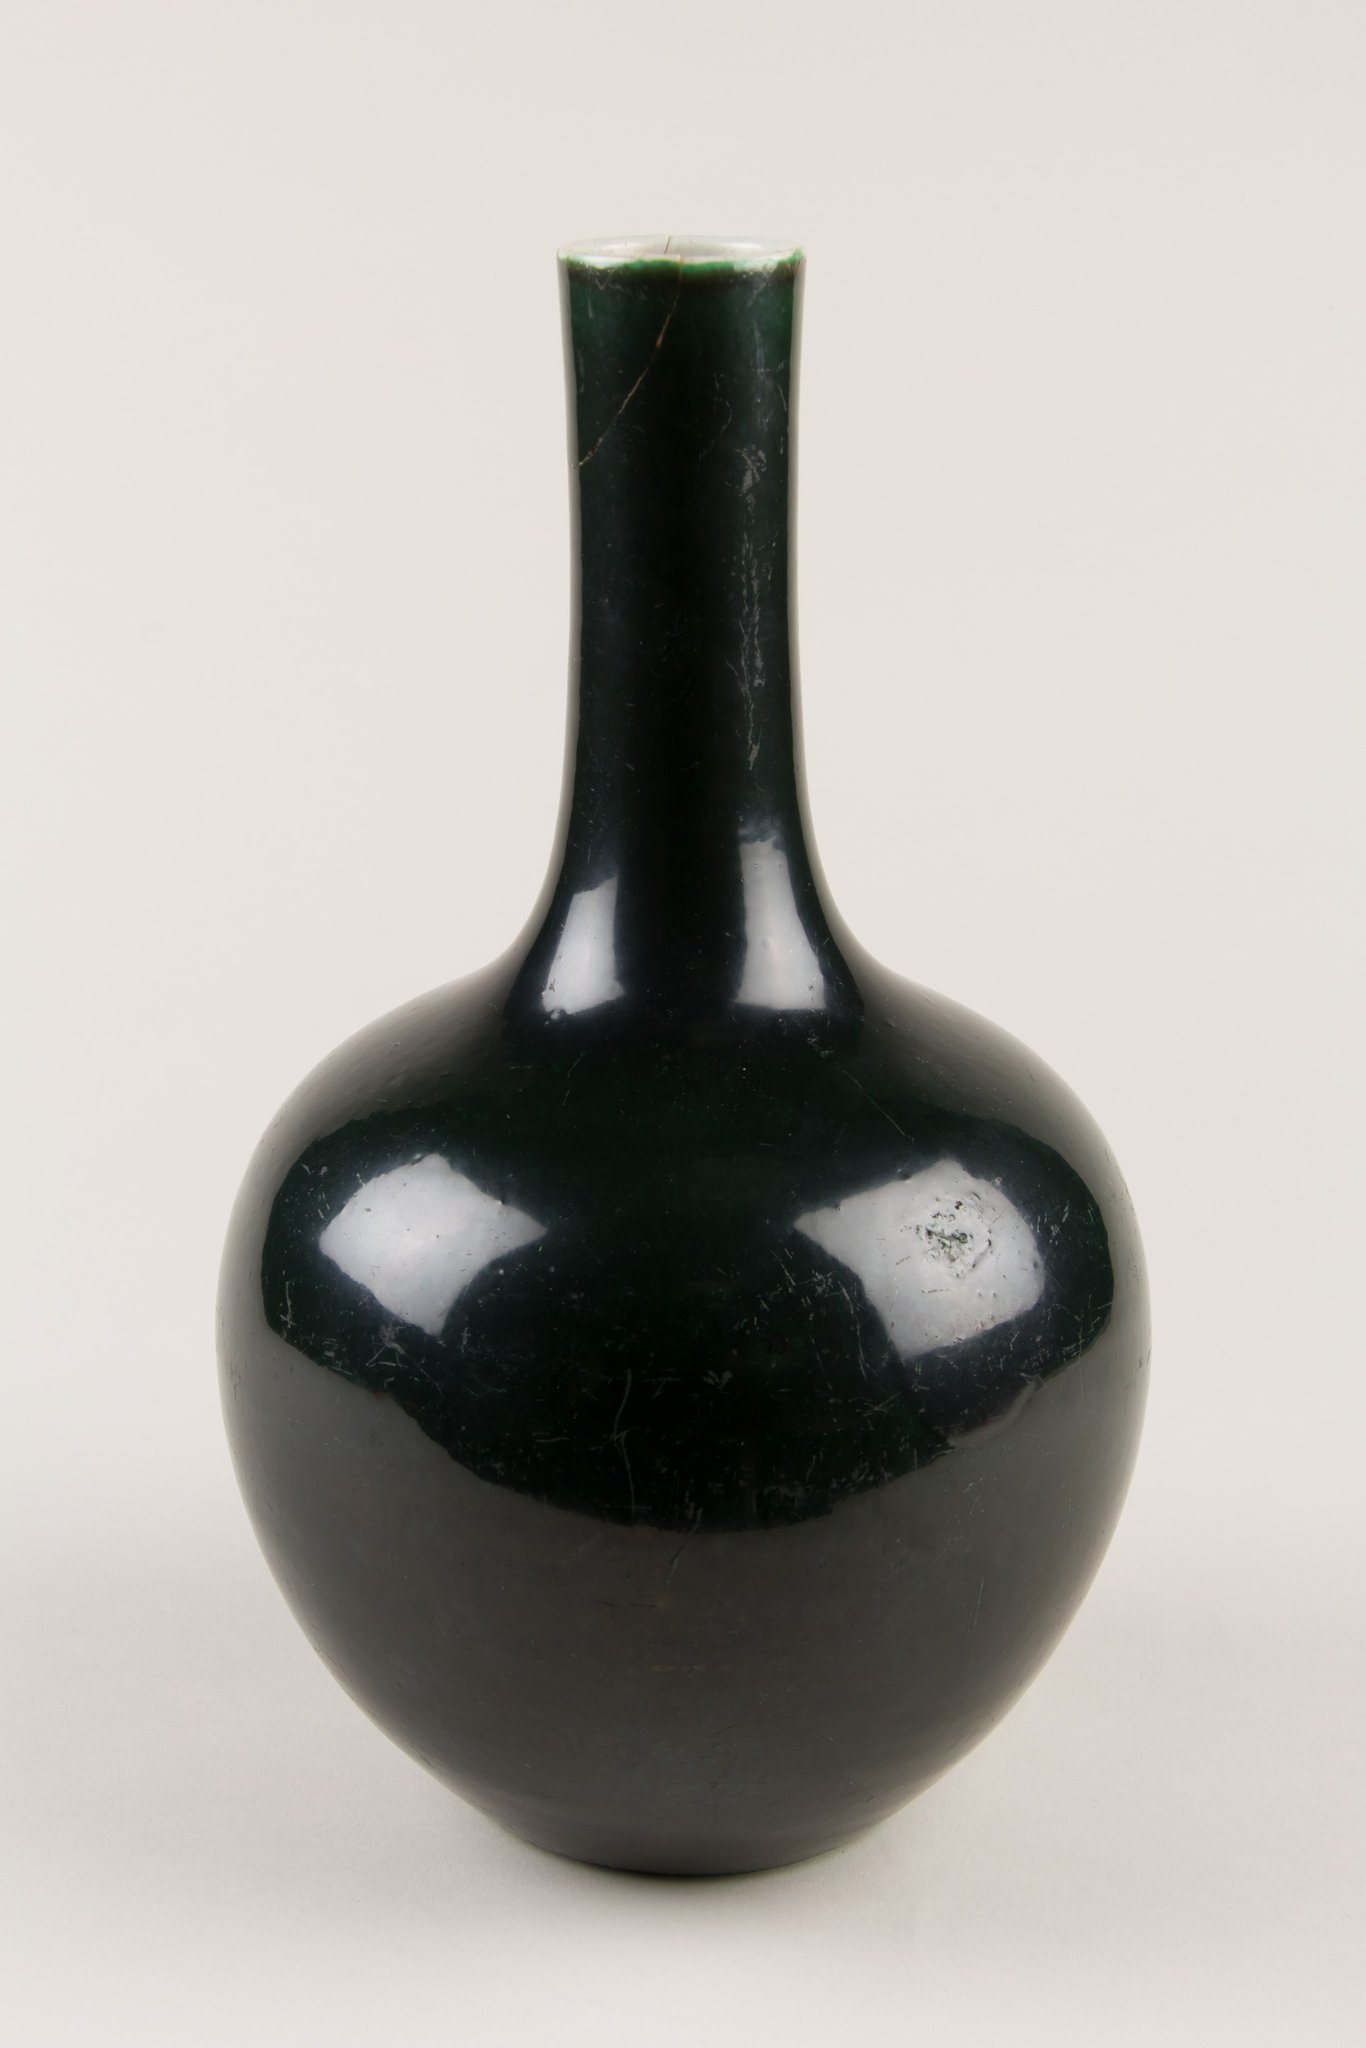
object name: vase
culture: chinese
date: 1801-1900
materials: glaze, porcelain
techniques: enamel